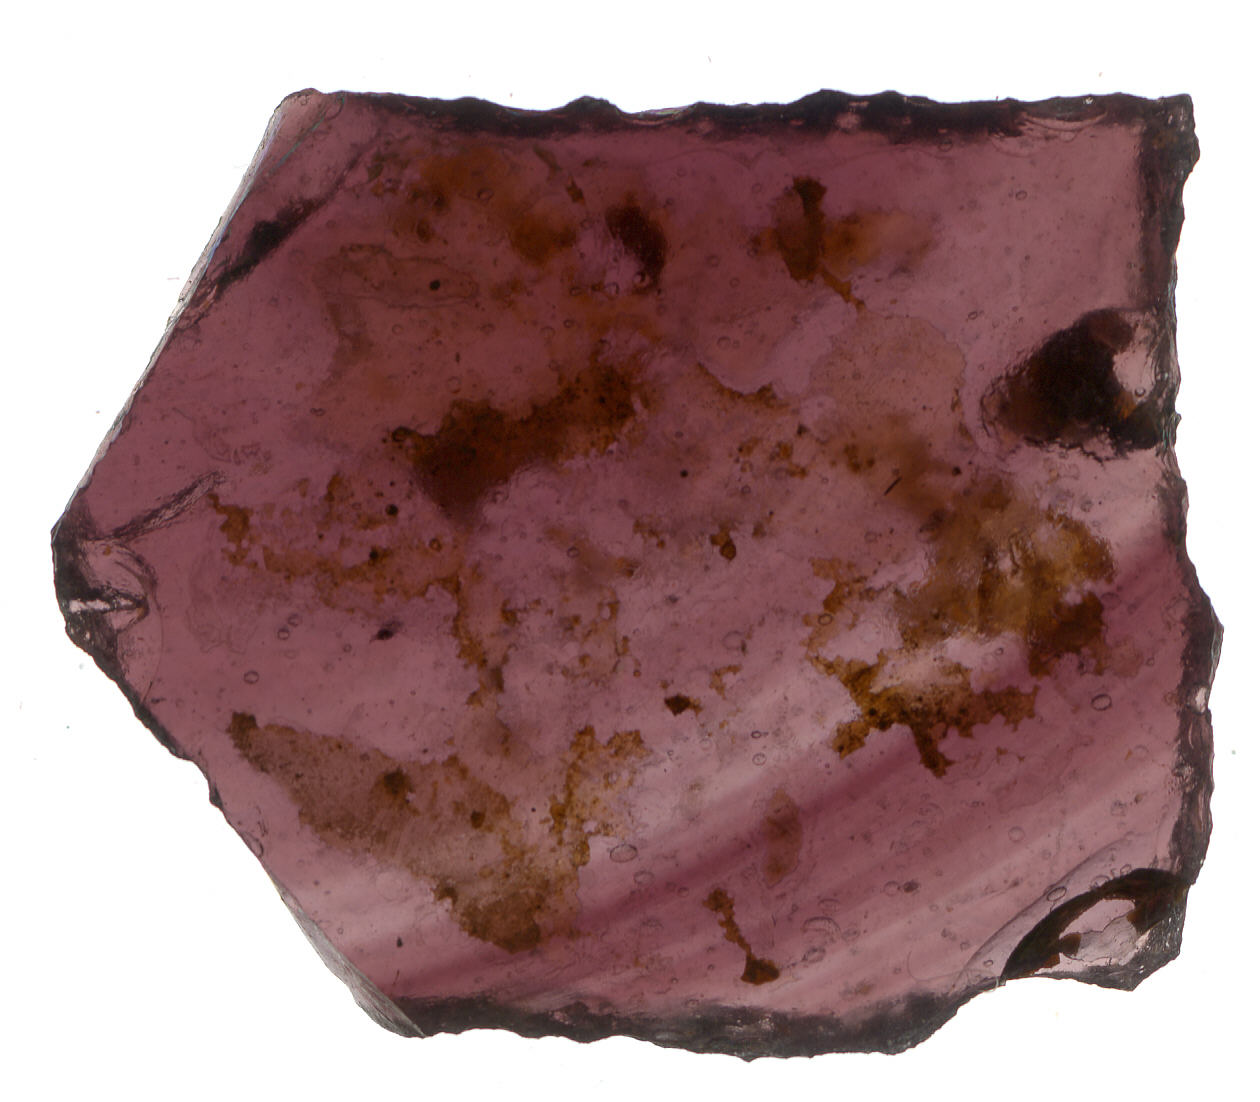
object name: fragment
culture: crusader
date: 1201-1300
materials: glass